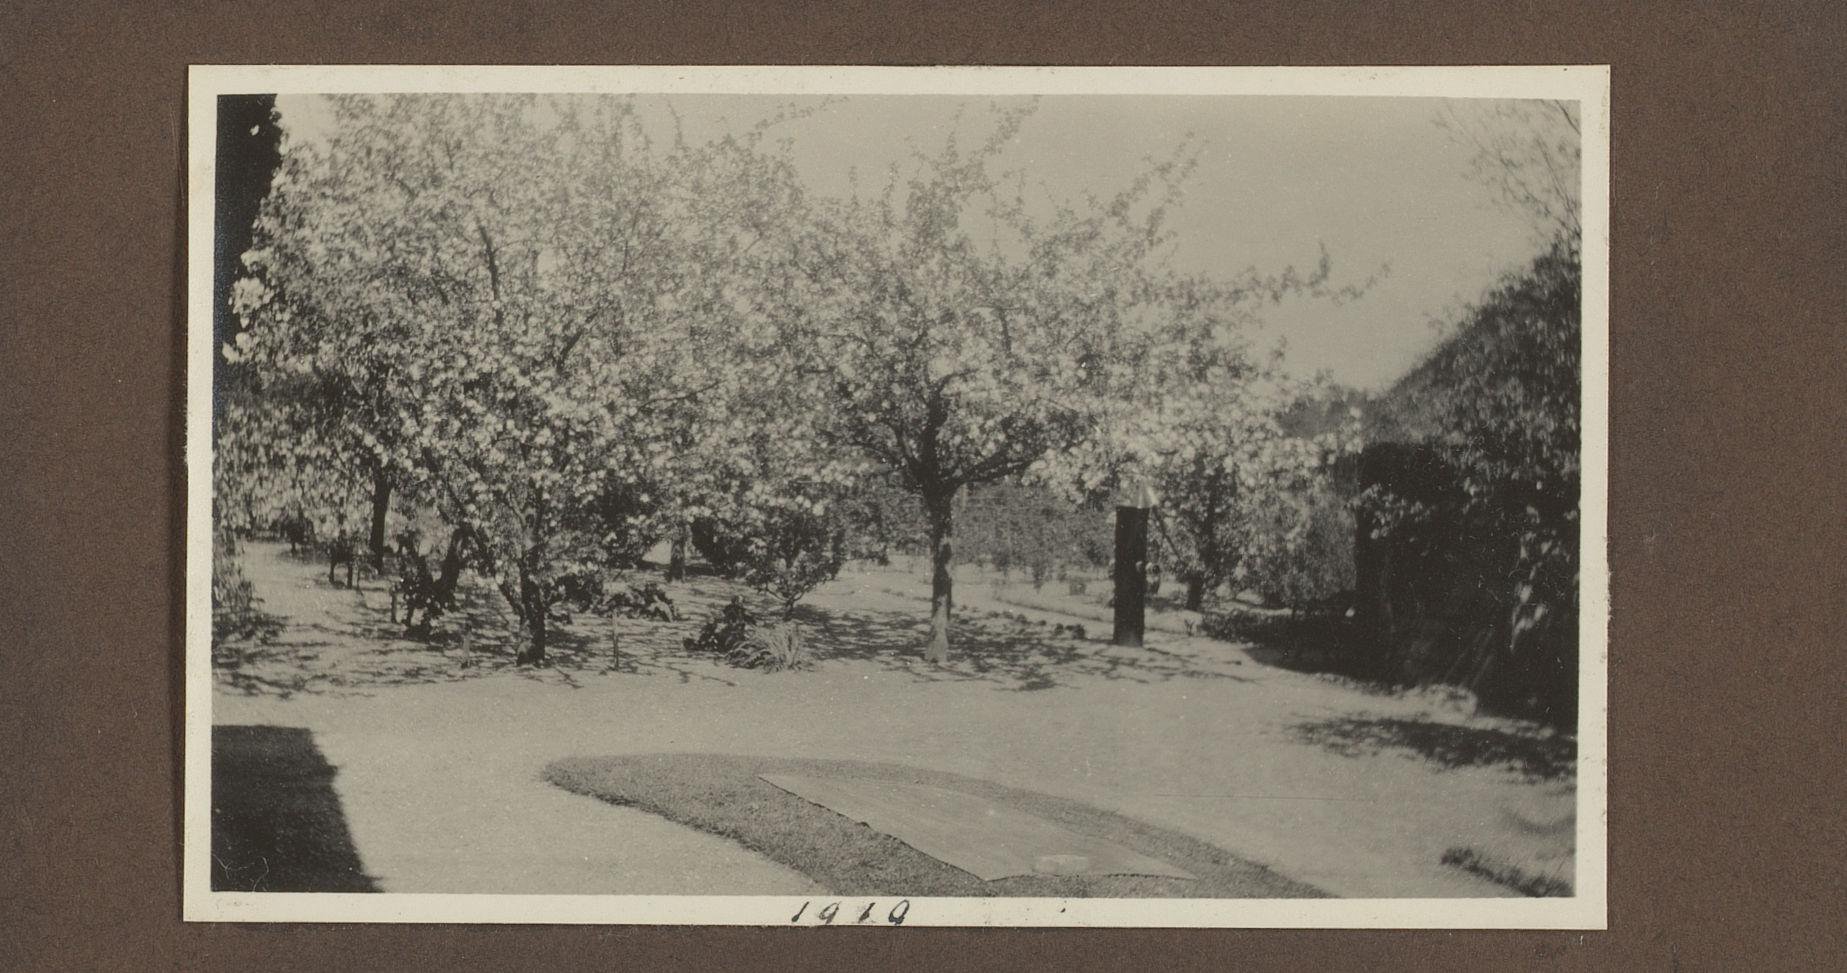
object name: photograph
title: Gezicht op een tuin met bloesembomen in bloei, vermoedelijk bij landhuis De Bijlakker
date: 1919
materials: paper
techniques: gelatin silver print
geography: laren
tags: trees: cherry-tree, (almond-blossom) flowers: almond-blossom, backyard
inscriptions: date: ‘1919’